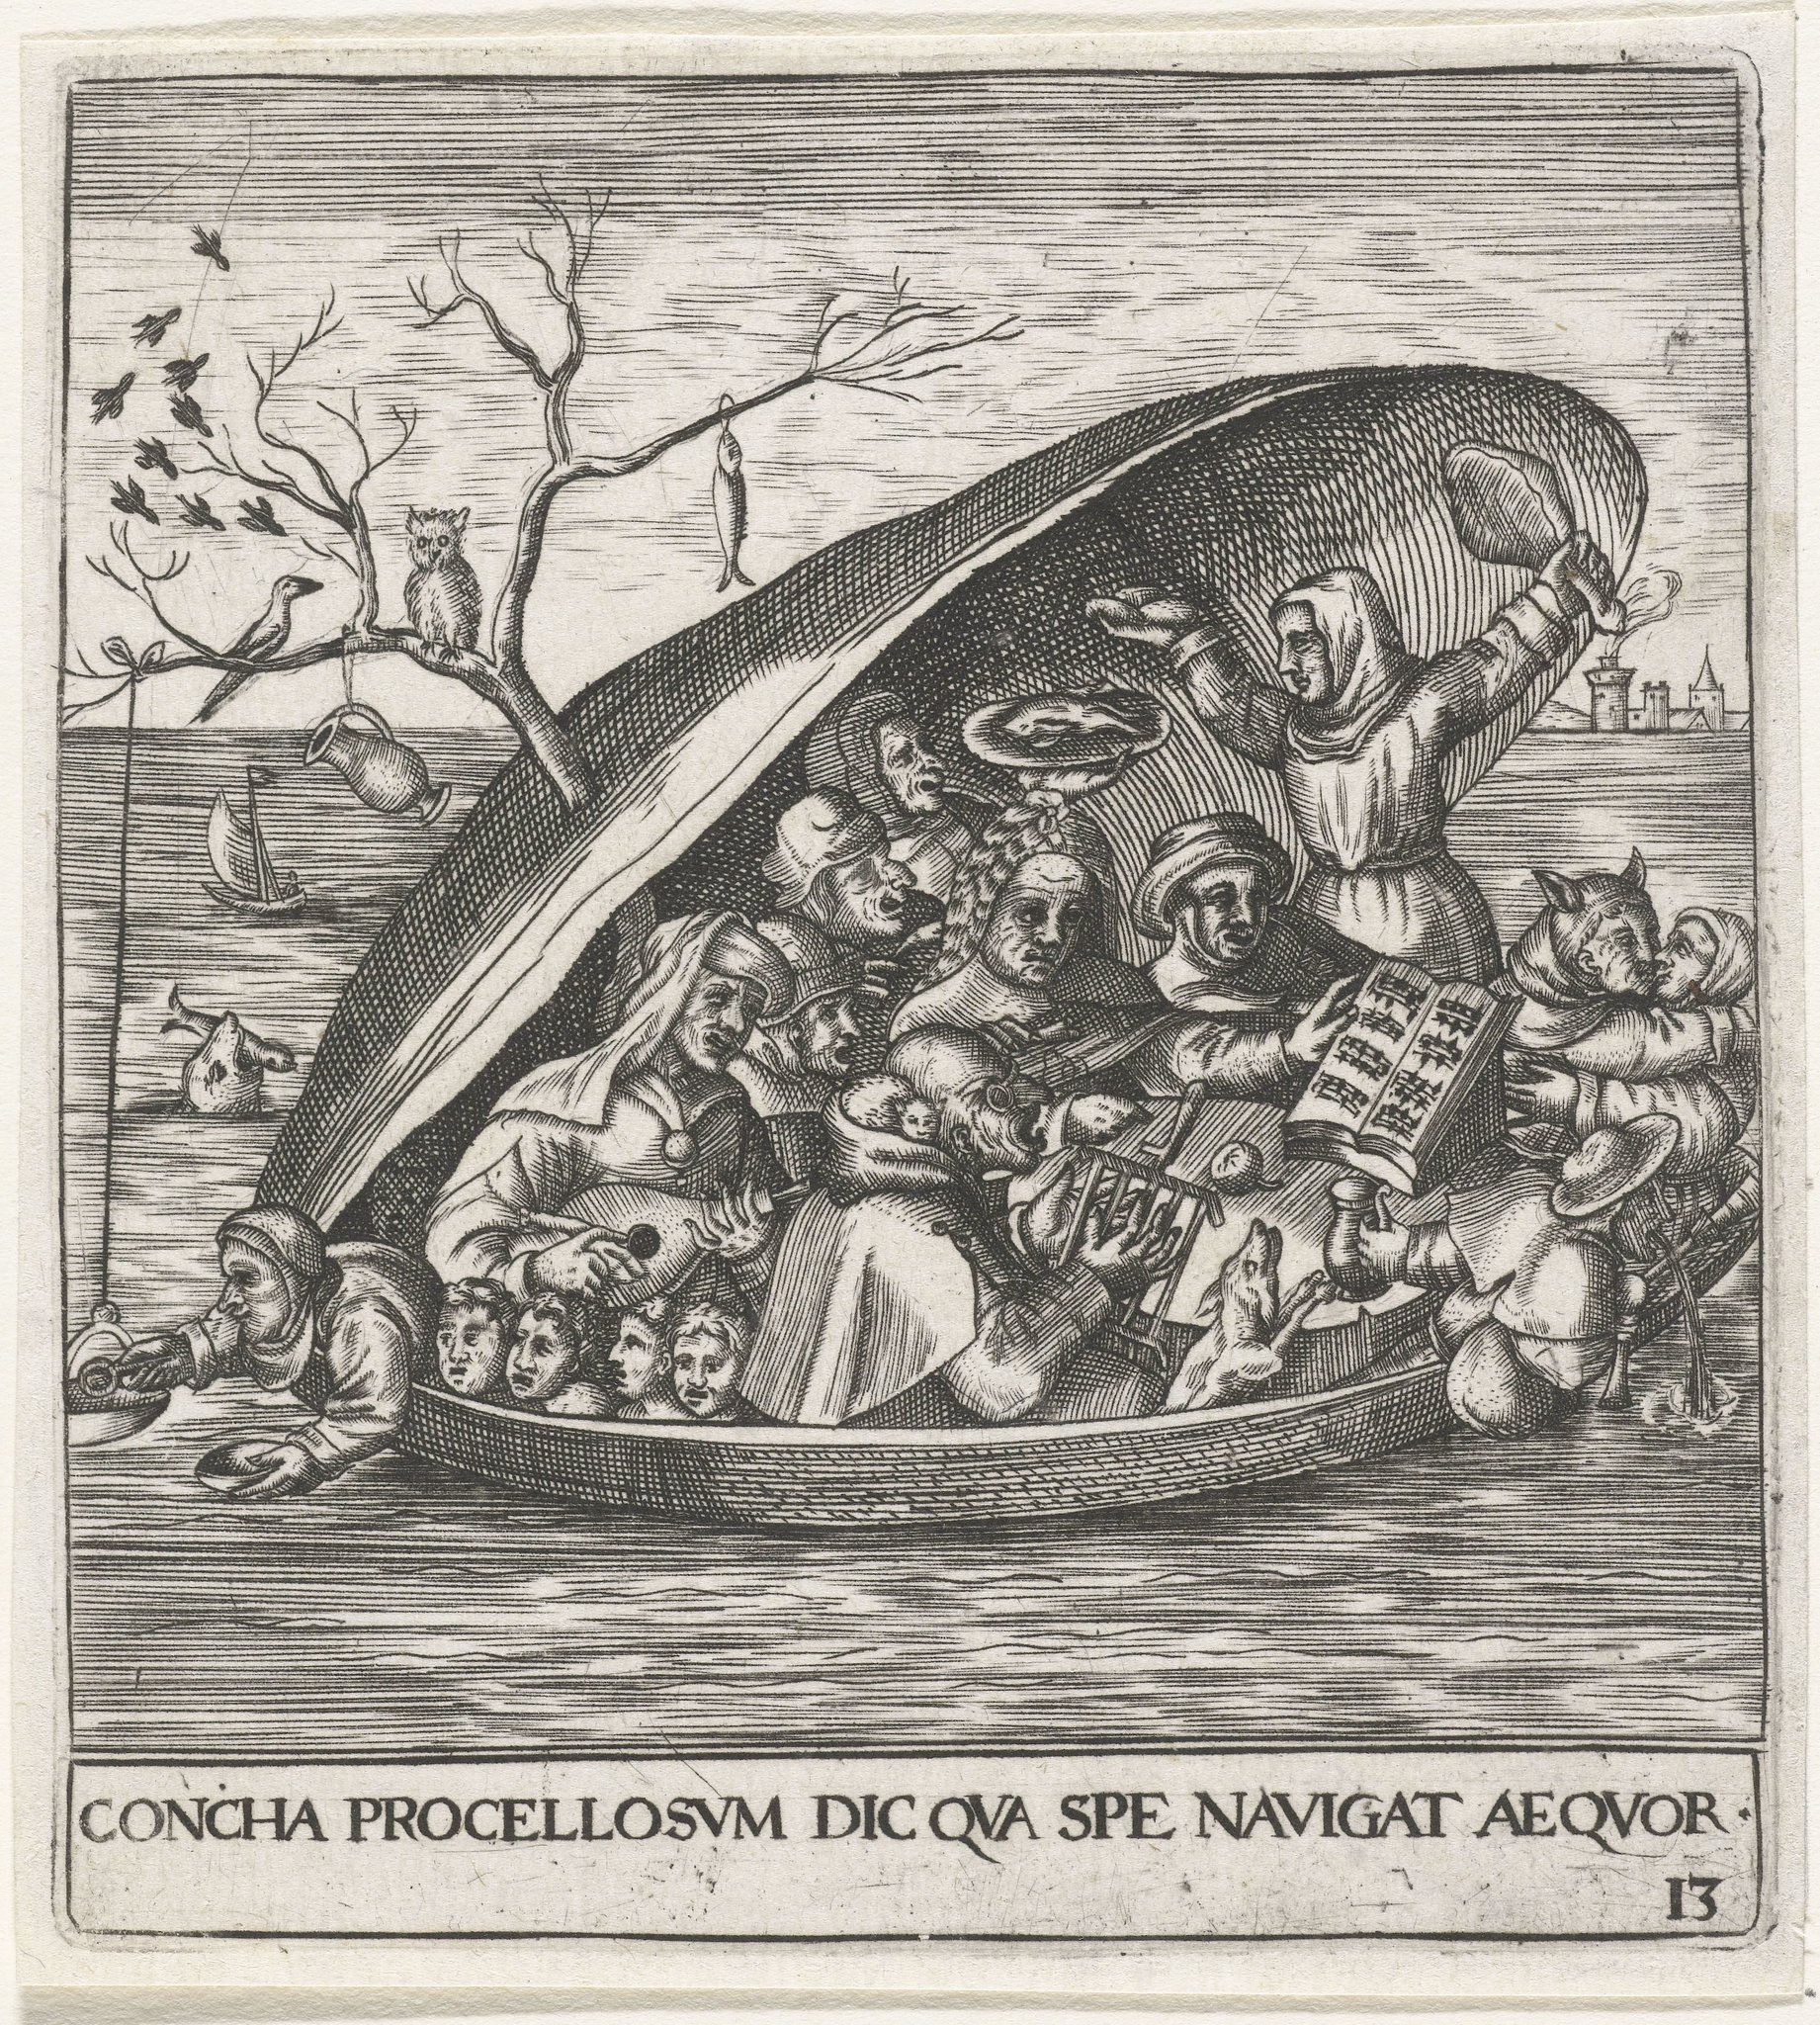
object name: cognizance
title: De Mosselschelp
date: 1596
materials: paper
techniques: engraving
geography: frankfurt am main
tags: existence and modes of existence (+ emblematical representation of concept), improvised musical instruments (kitchen-utensils, etc.) - cc - out of doors, monks and nuns, molluscs: mussel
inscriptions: collector's mark: Lugt 240, number: ‘13’, inscription: ‘CONCHA PROCELLOSUM DIC QUA SPE, NAVIGAT AEQUOR’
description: Satire op de kerkelijke stand in de 16de eeuw. Een losbandig gezelschap van nonnen en paters zit opeengepakt in een open mosselschelp. Er wordt gegeten, gevreeën en gemusiceerd. Behalve de doedelzak worden er geen echte maar zogenaamde charivari instrumenten - hier het haardrooster en de blaasbalg - "bespeeld". Op deze manier wordt duidelijk gemaakt dat hier de morele normen en waarden van de kloosterlingen worden omgedraaid. Embleem nr. 13 in Emblemata Saecularia, 1596 en nr. 34 in de tweede uitgave van 1611.